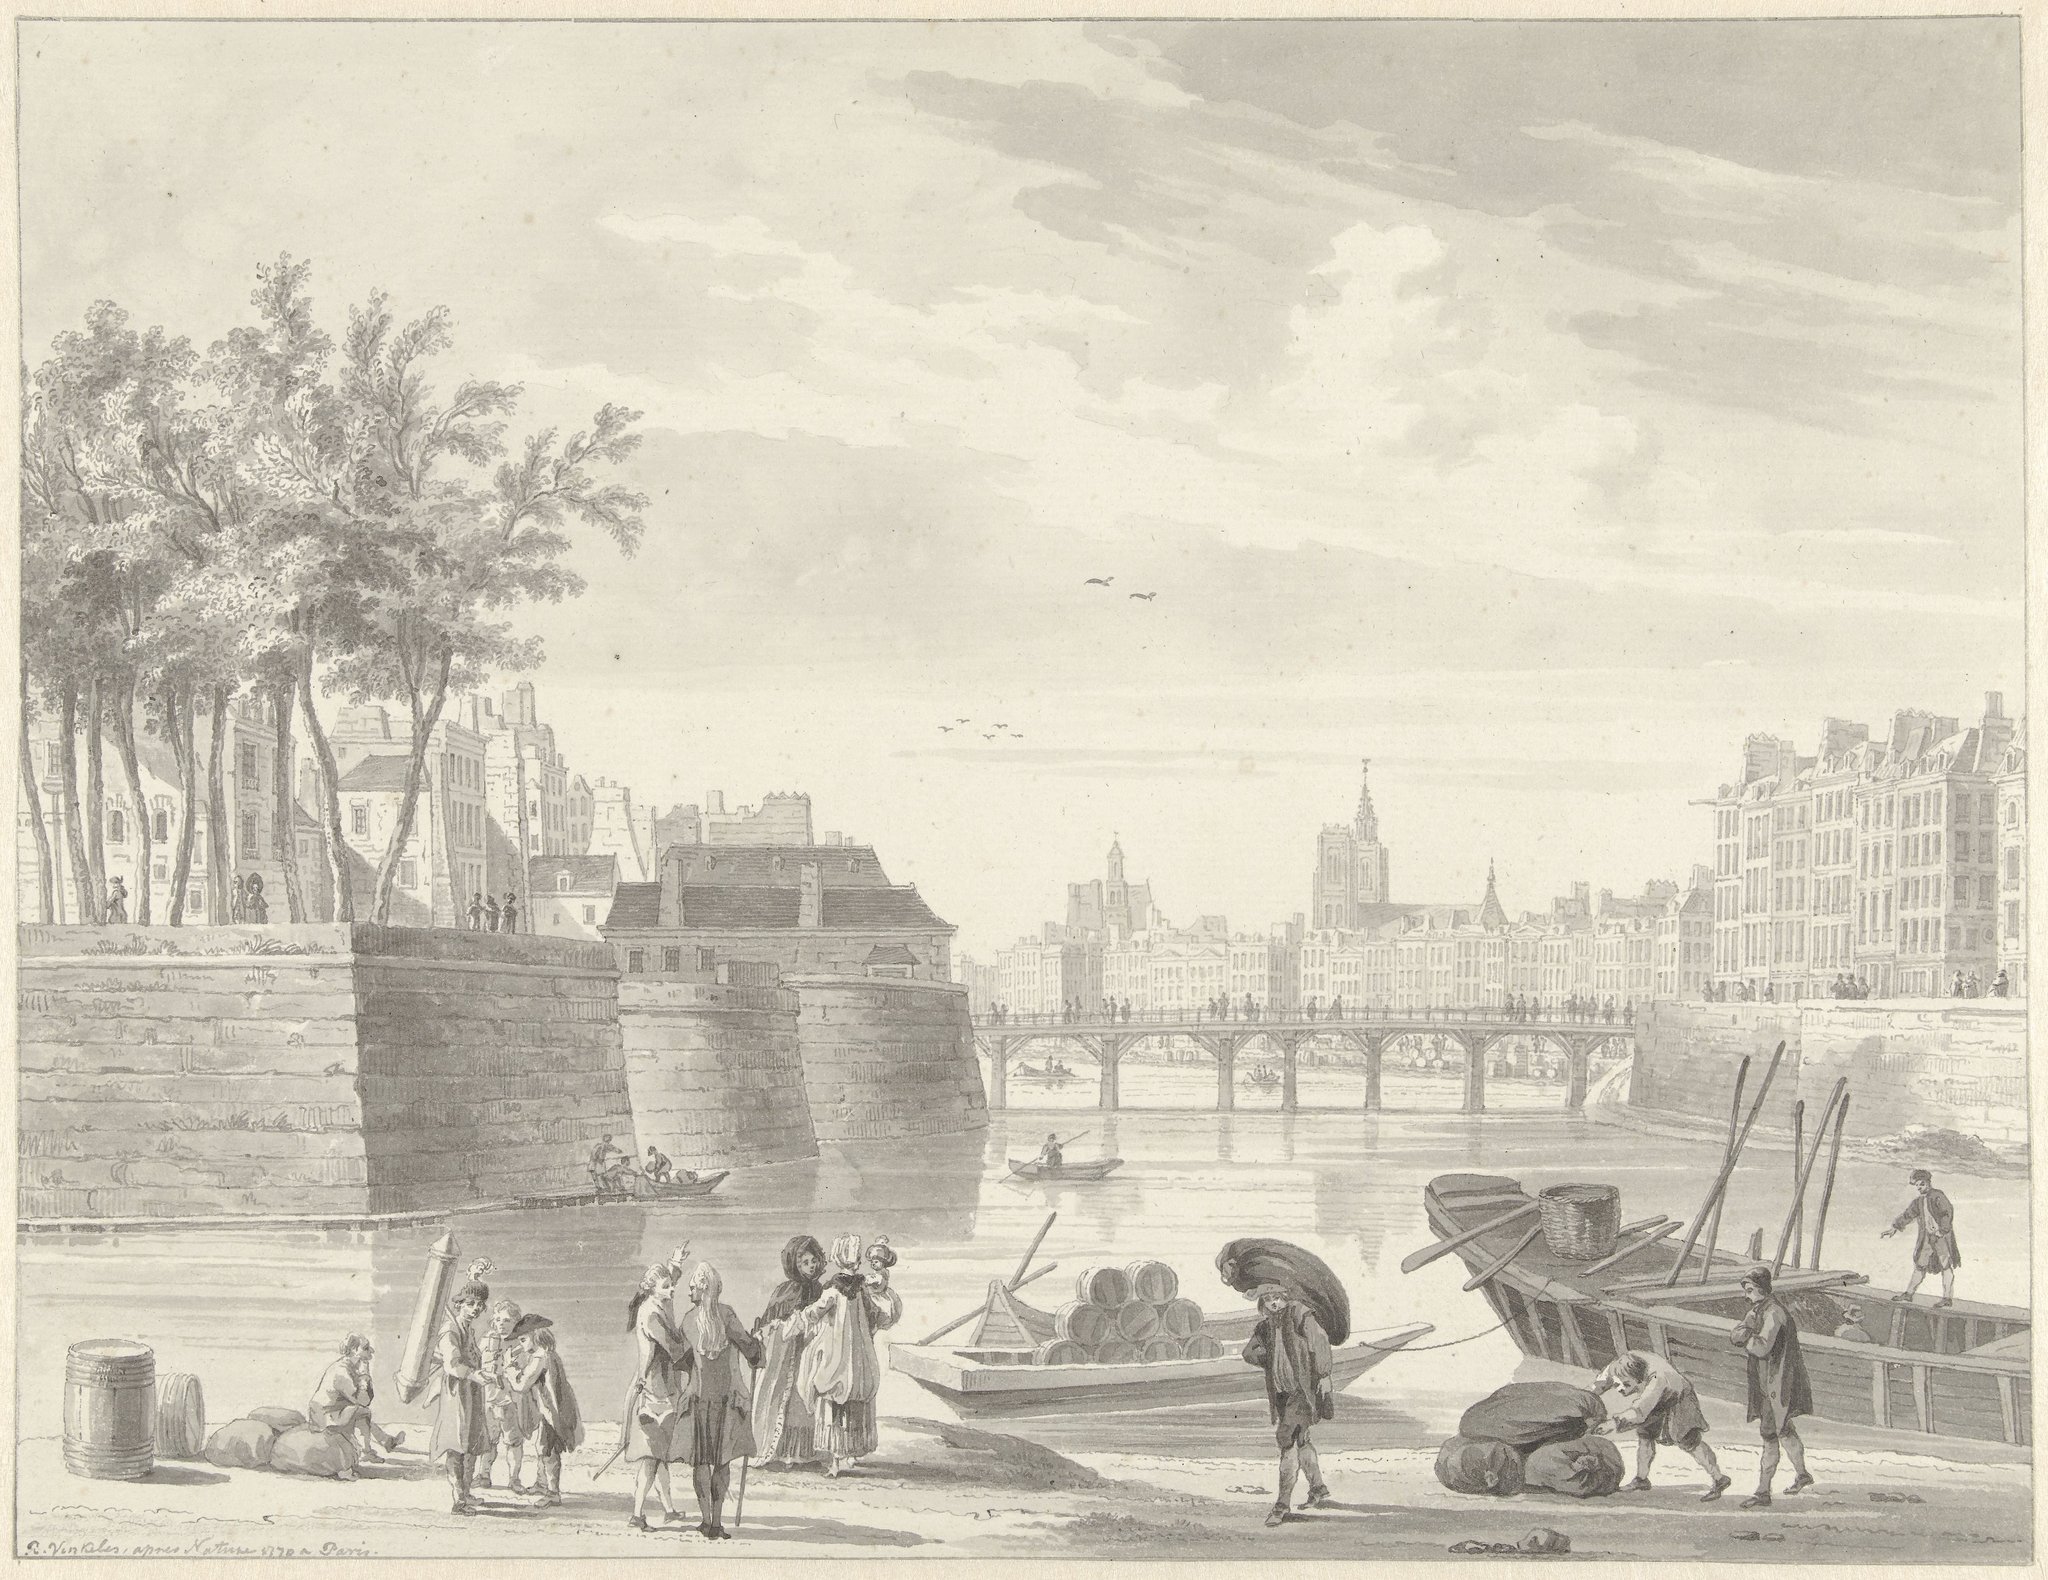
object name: drawing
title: Gezicht op de Pont Rouge, Parijs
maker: reinier vinkeles (i)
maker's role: draughtsman, print maker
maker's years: 1741-1816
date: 1770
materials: ink, paper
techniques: brush, pen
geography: paris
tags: quay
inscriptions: inscription: ‘Le Quaij de Tournelle, on voit le coin de Jardin des enfants de Cour; sur le pont de Bois, ou Rouge, jusque les eglises St Jean et St Gervain a Paris’, inscription: ‘R. Vinkeles, apres Nature 1770 a Paris’